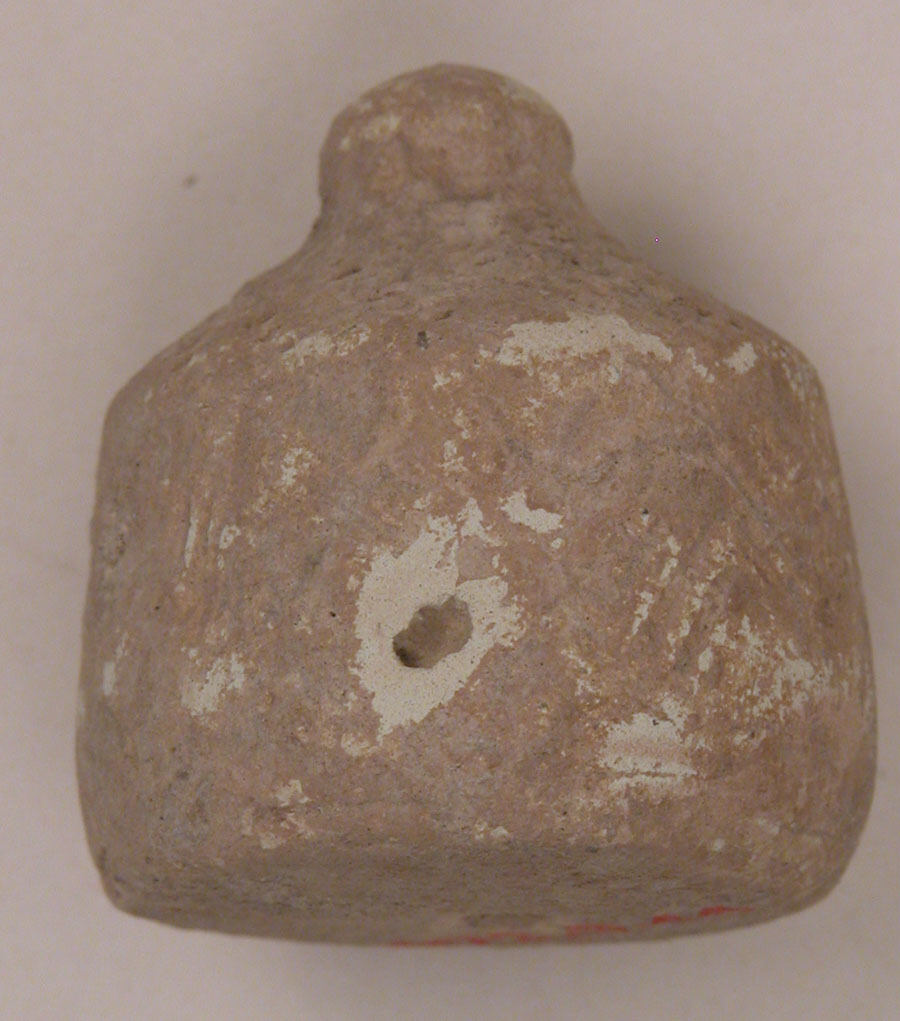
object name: chess piece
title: Chess Piece, Pawn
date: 701-1100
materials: earthenware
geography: western islamic lands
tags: chess,games